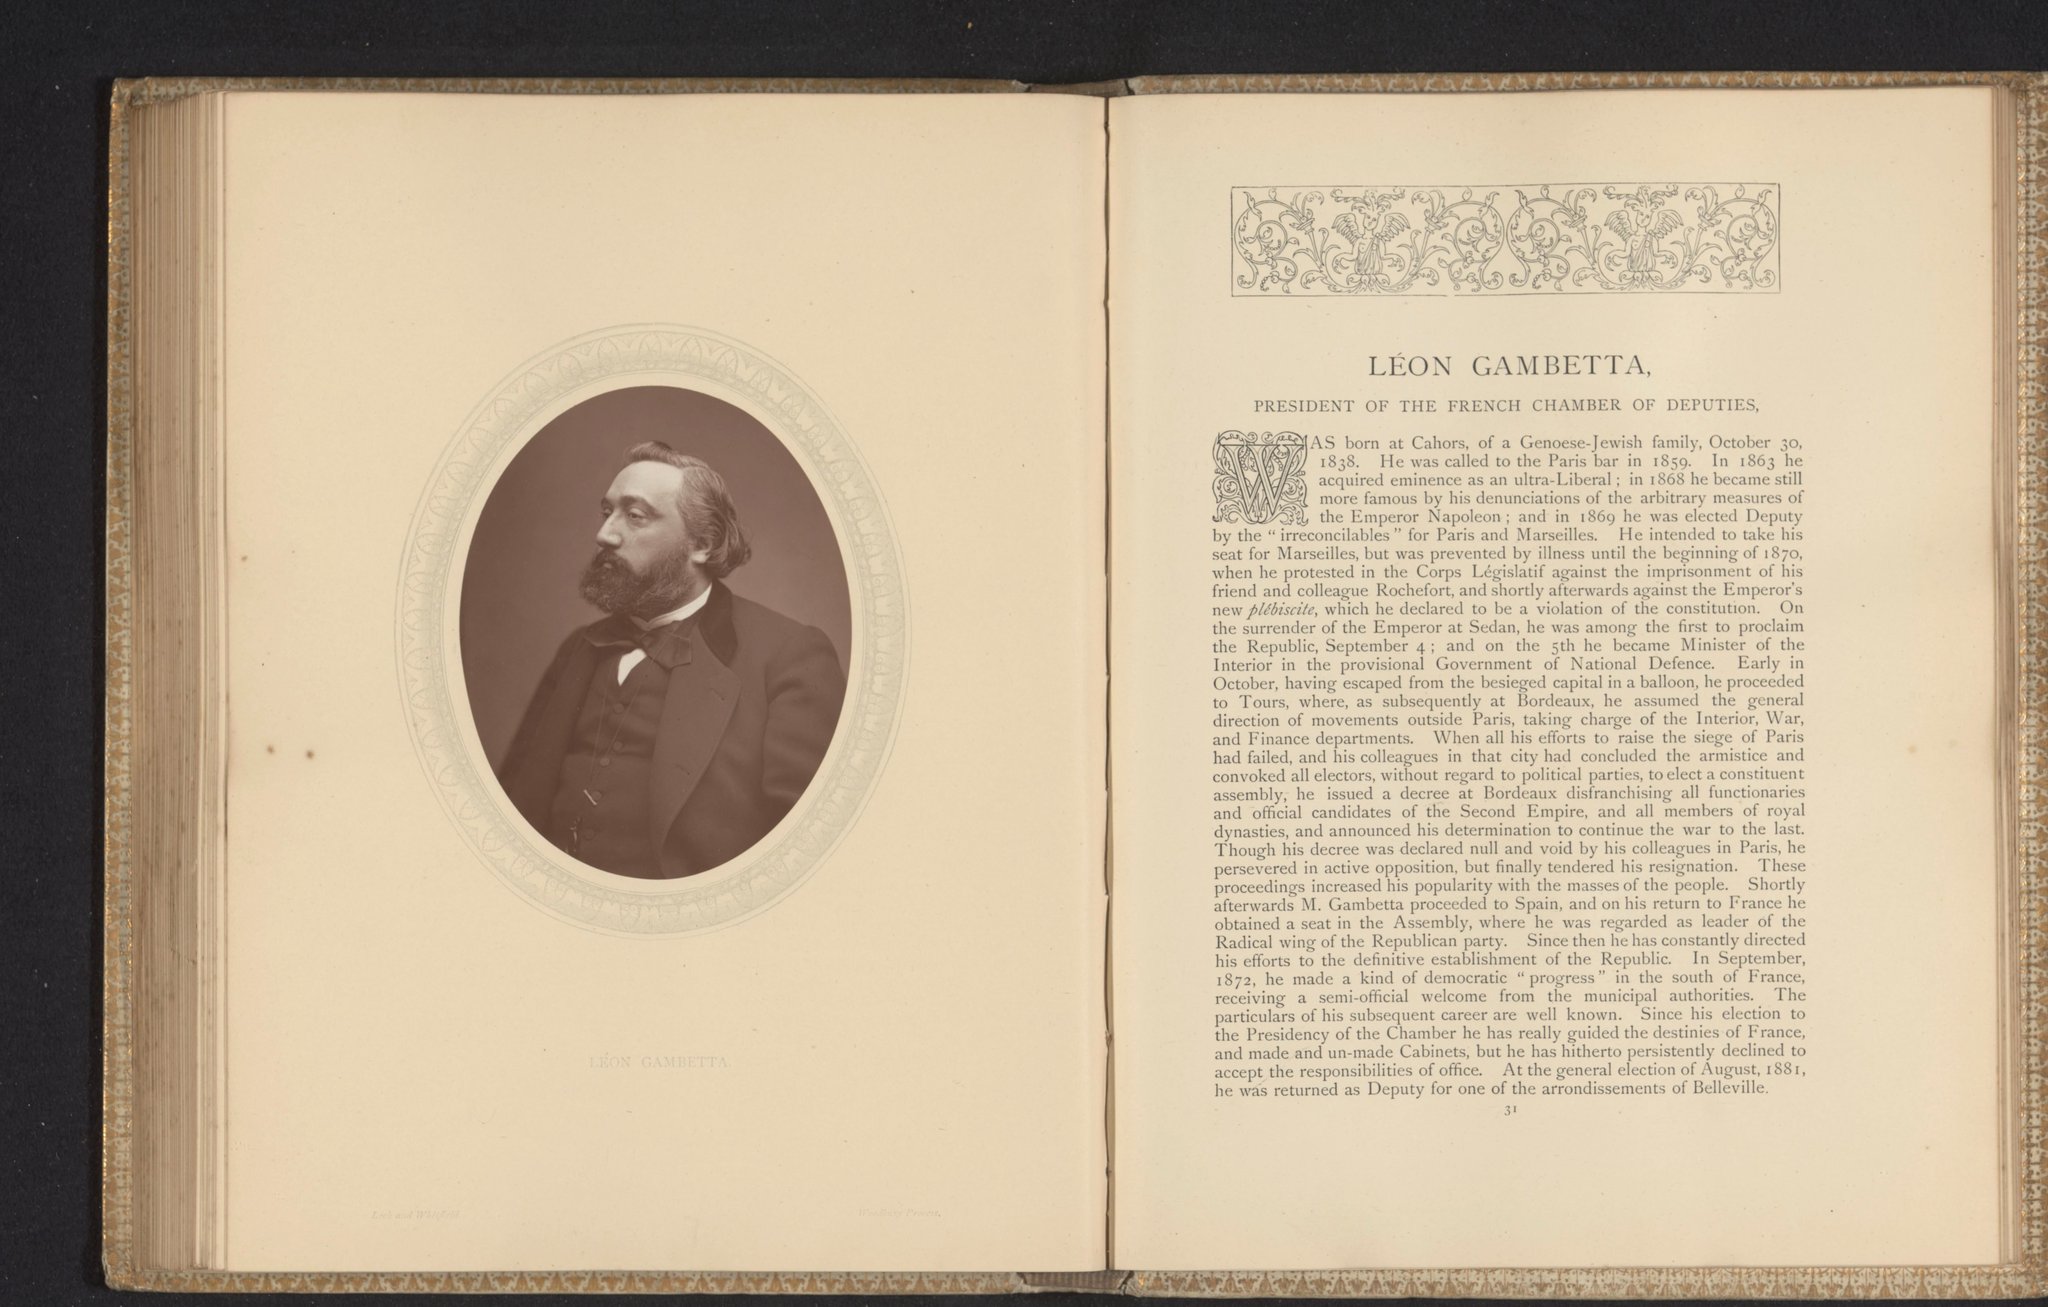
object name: page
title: Léon Gambetta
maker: Anonymous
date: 1877-1882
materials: paper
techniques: woodburytype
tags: prime minister, historical persons (portraits and scenes from the life) (+ (full) bust portrait)